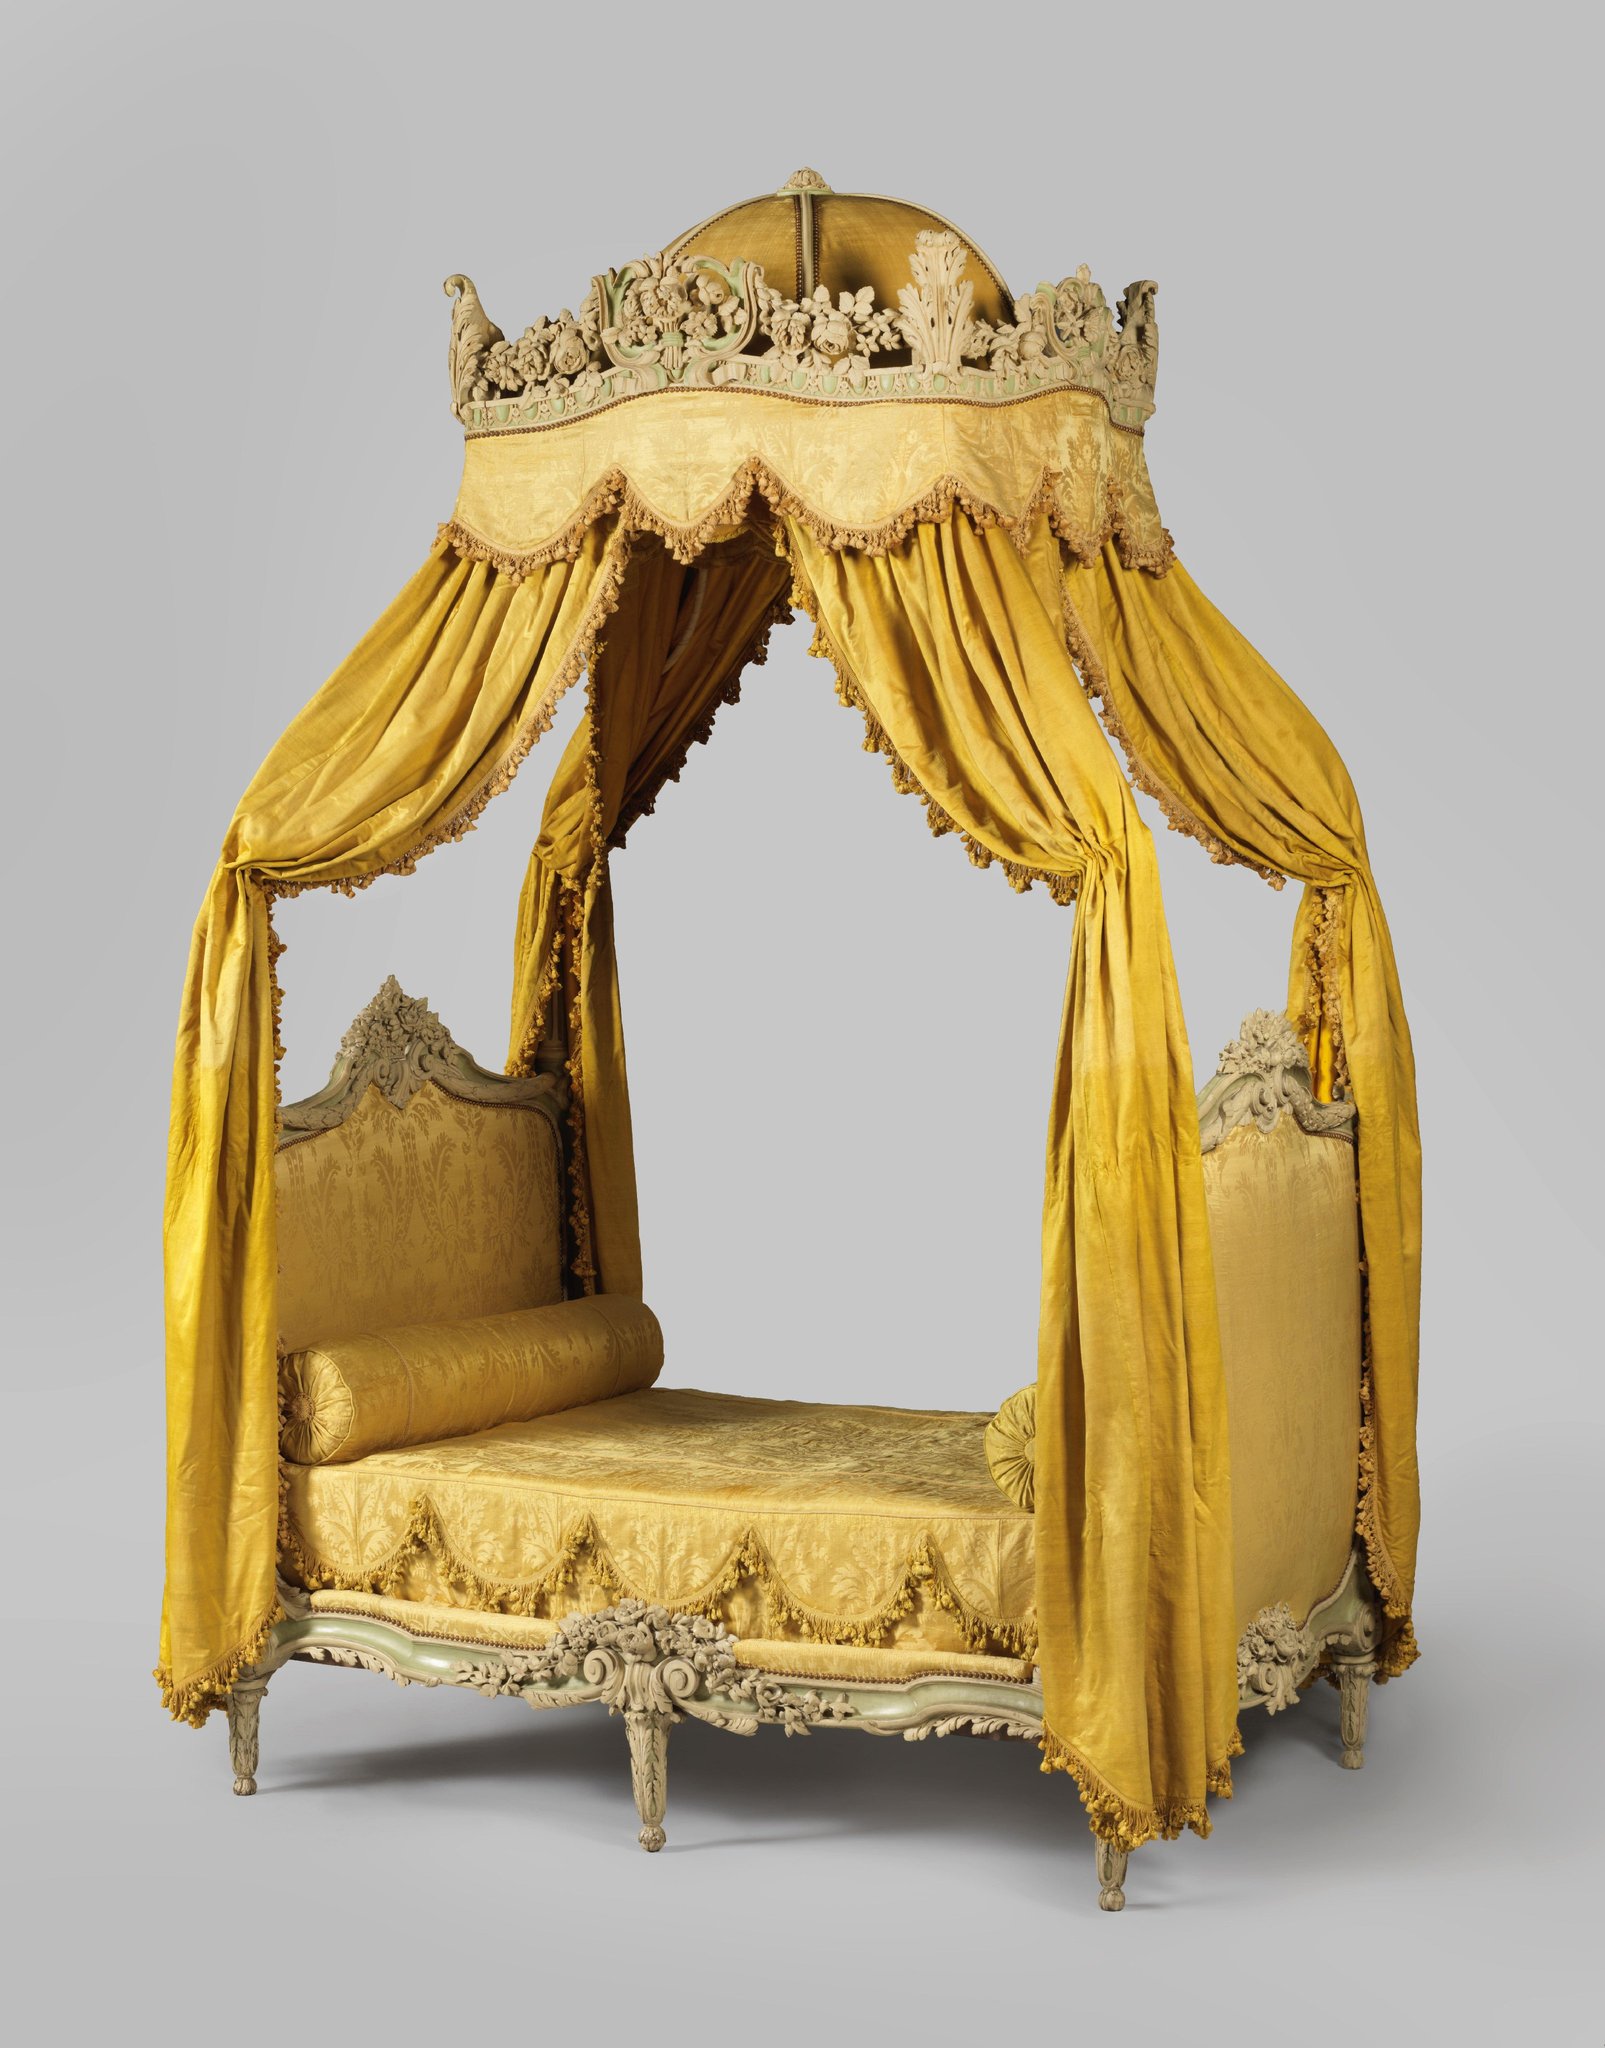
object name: furniture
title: Rolkussen van het Lit à la Polonaise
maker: Anonymous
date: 1775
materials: wood, copper, iron, paint, textile, silk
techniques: cutting, damask, painted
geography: france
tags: bed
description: Rolkussen van zijde damast van het bed in doos.